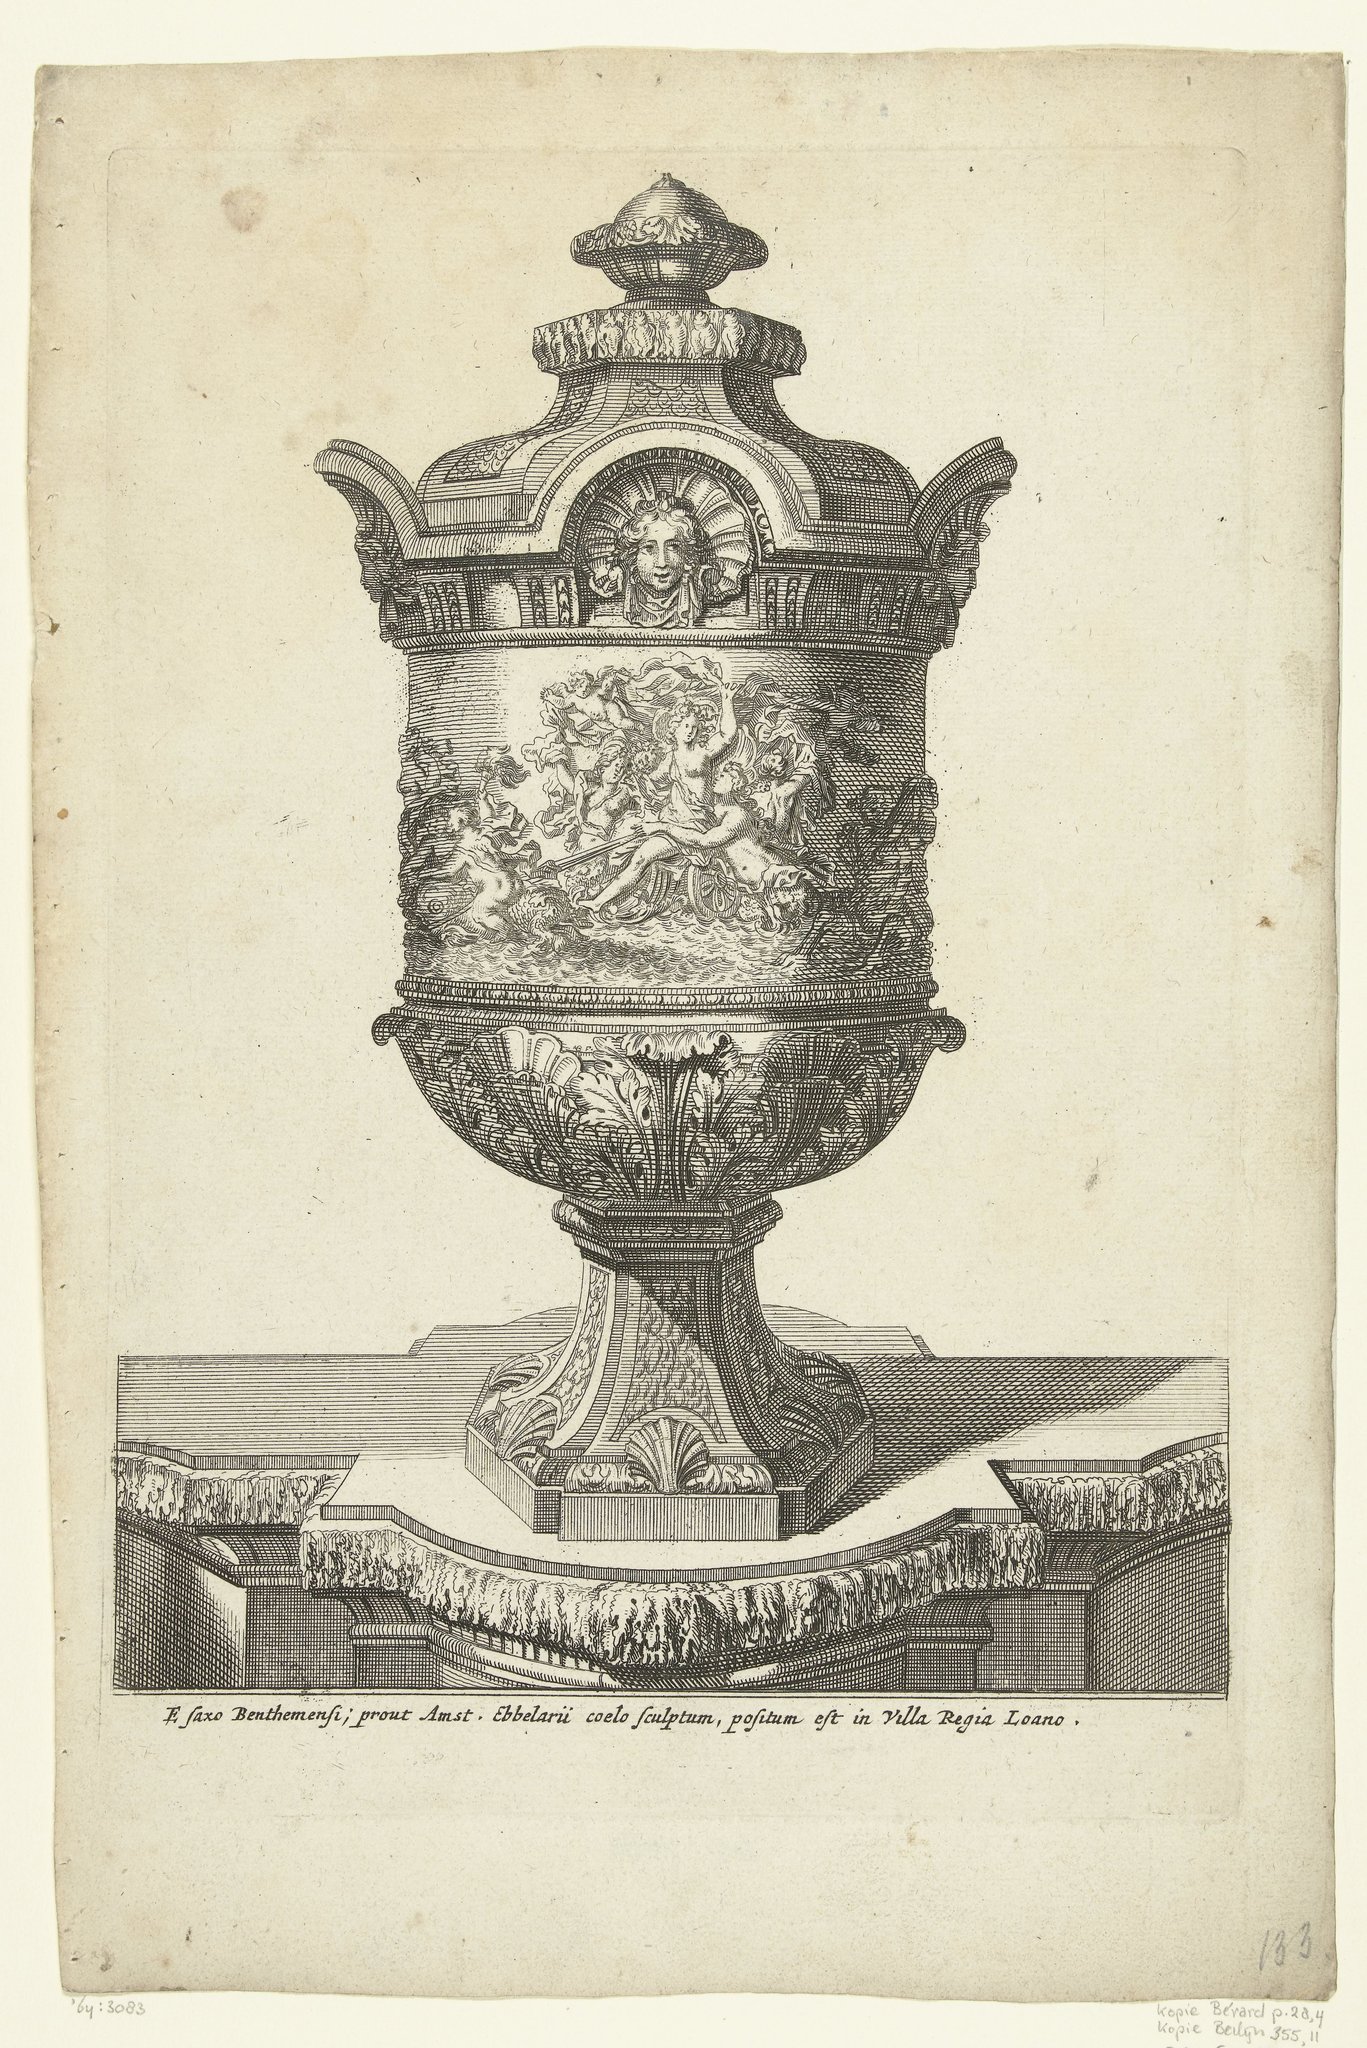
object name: ornament print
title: Vaas met de triomf van Amphitrite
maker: Anonymous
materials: paper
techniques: etching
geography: netherlands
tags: triumph of amphitrite, garden vase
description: Vaas op een achthoekige voet met deksel. Op het cilindervormig lichaam van de vaas de triomf van Amphitrite. In de ondermarge een Latijnse tekst. Kopie naar blad uit de serie Vasses de la Maison Royalle de L'oo. Uit serie van 6 bladen.